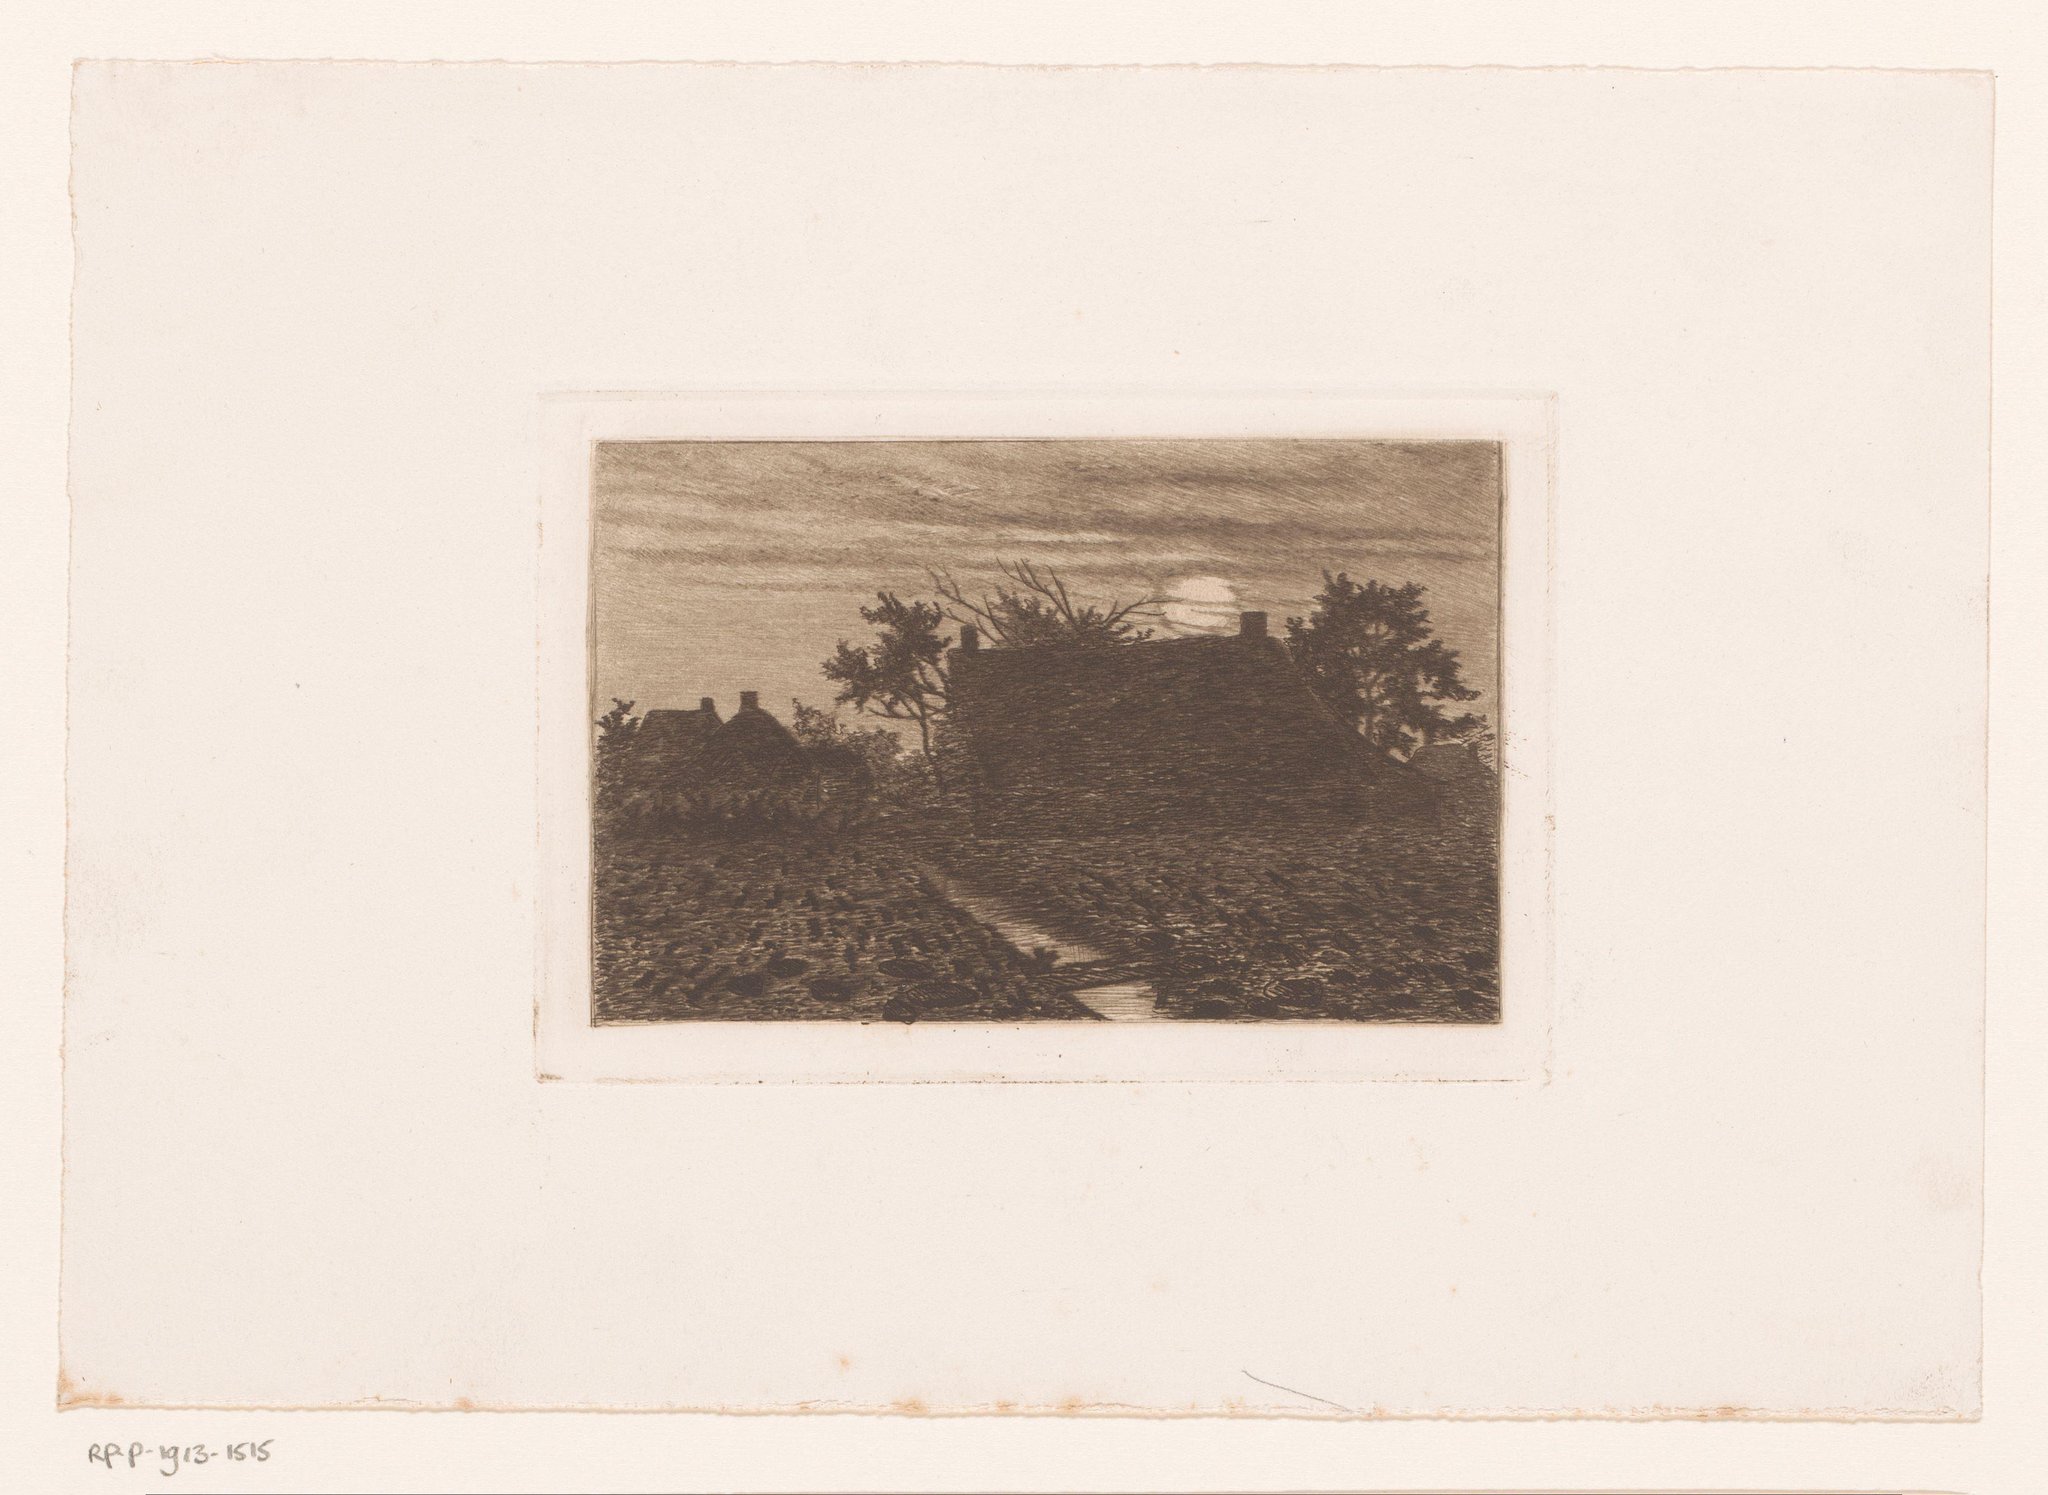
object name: print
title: Landschap met een boerderij aan een beek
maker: h. van meerbeeck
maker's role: print maker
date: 1850-1913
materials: paper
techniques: drypoint, etching, intaglio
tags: moonlight, landscapes with waters, waterscapes, seascapes (in the temperate zone), farm or solitary house in landscape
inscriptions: collector's mark: Lugt 2228